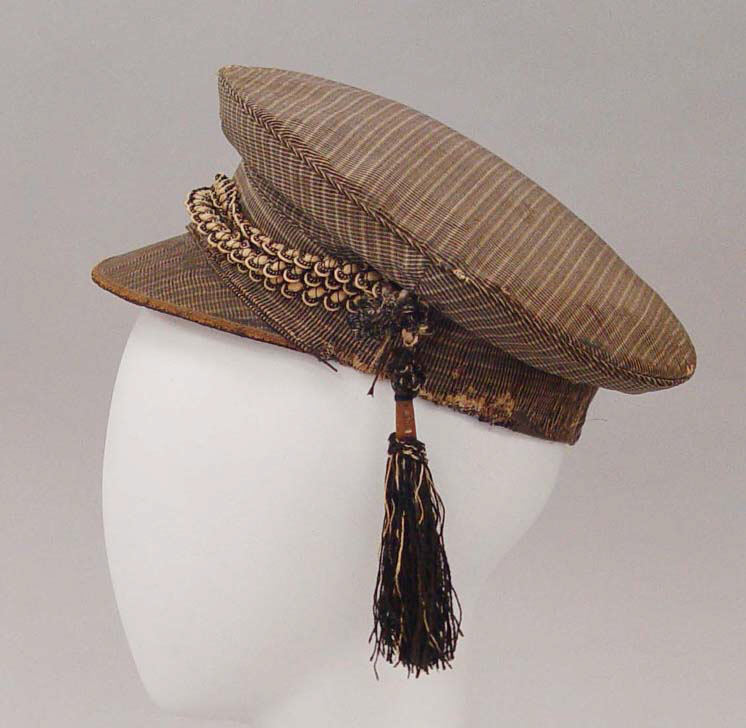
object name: cap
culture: american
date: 1862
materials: cotton, leather, silk